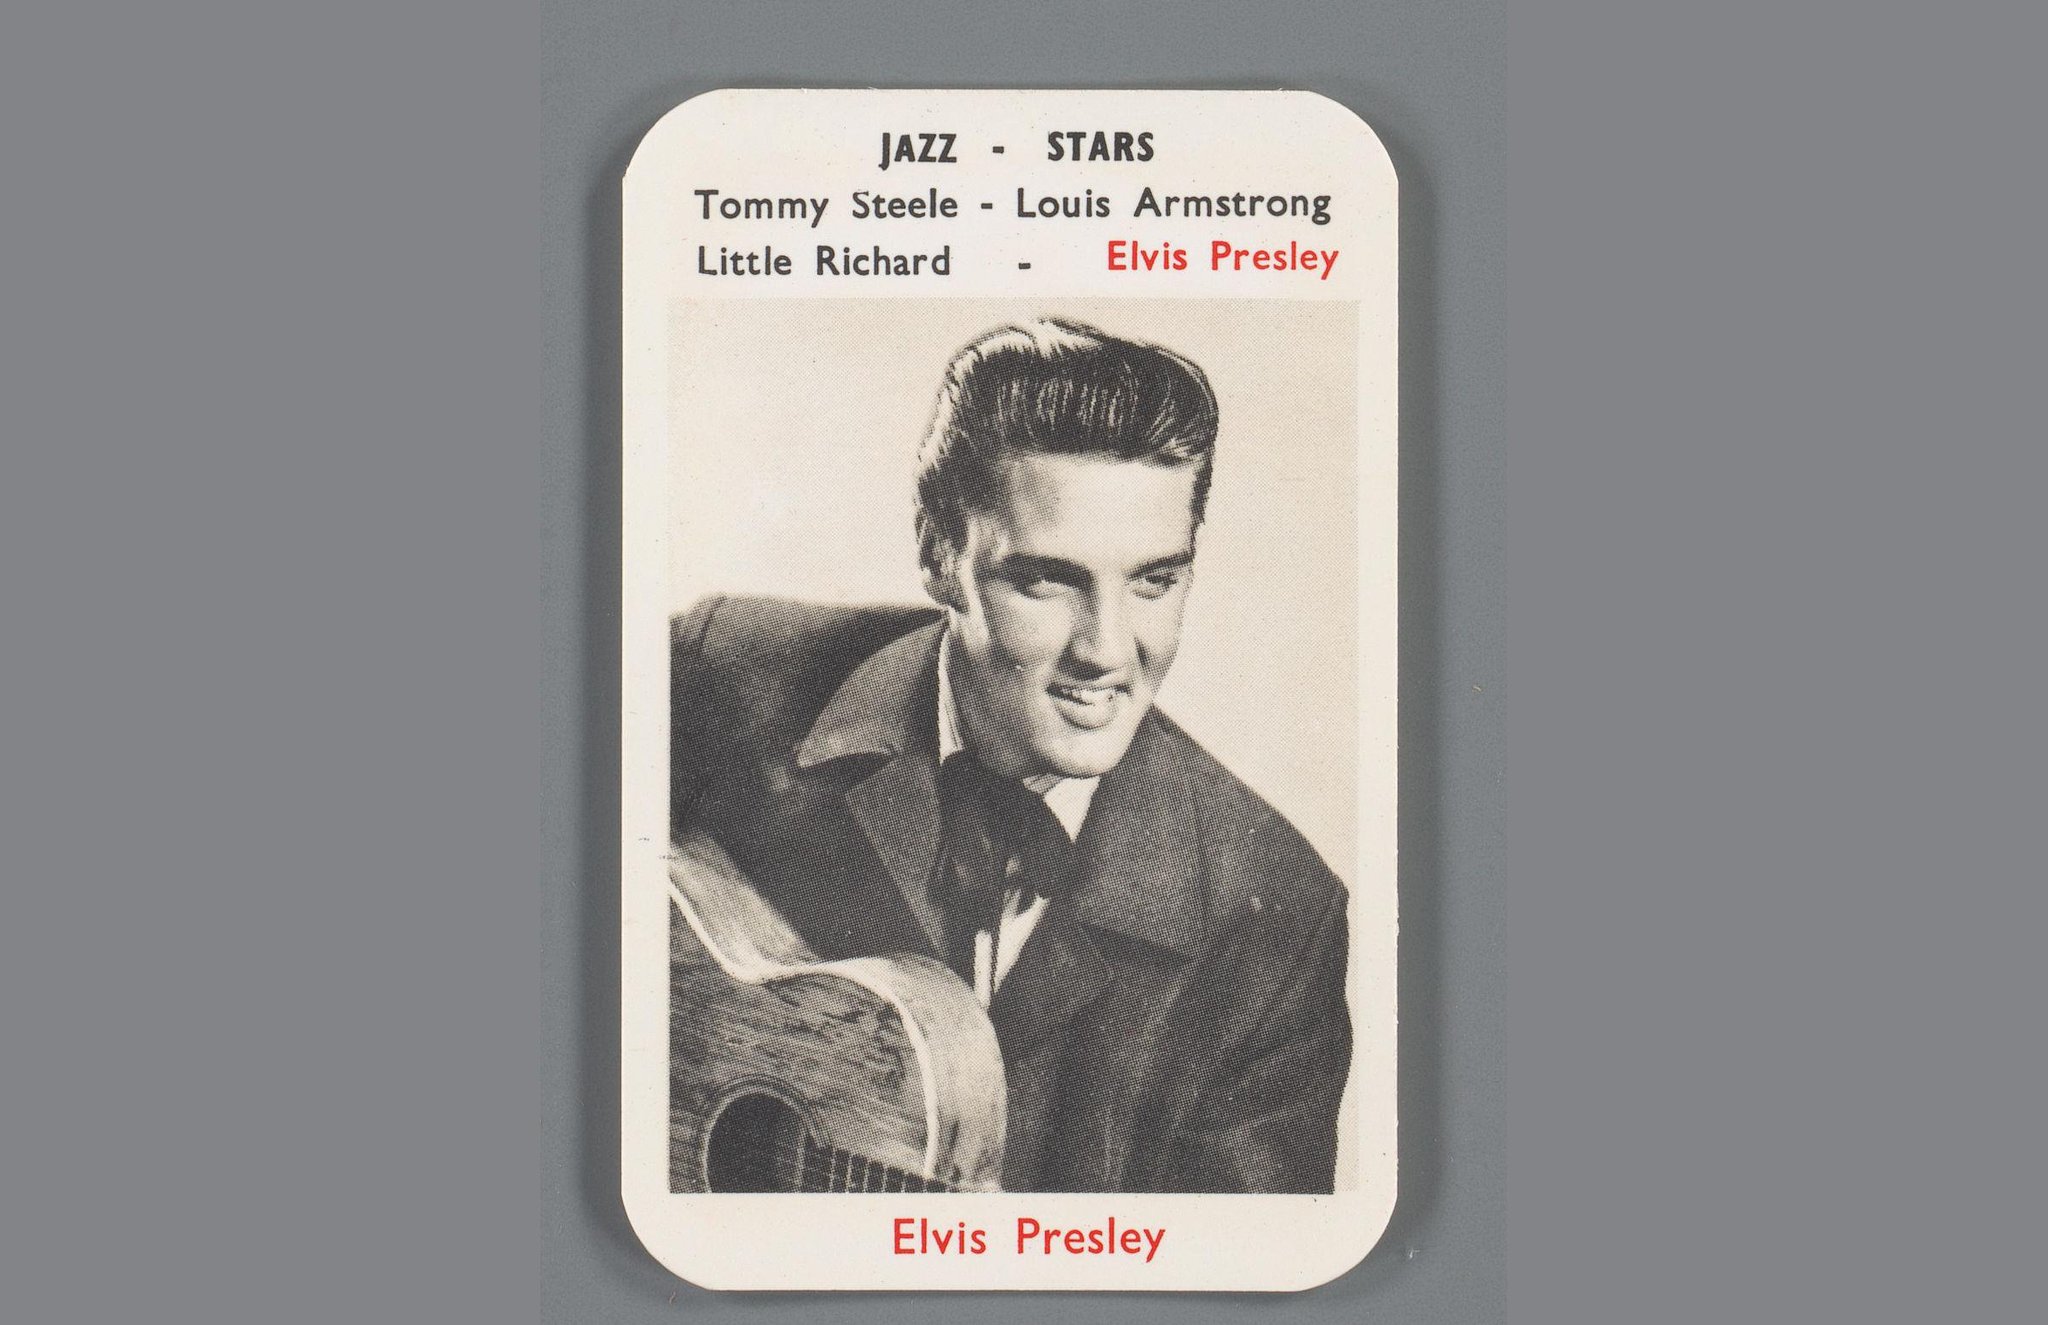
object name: playing card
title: Jazz Stars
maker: Anonymous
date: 1960-1970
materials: paper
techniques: autotype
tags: portrait of a musician